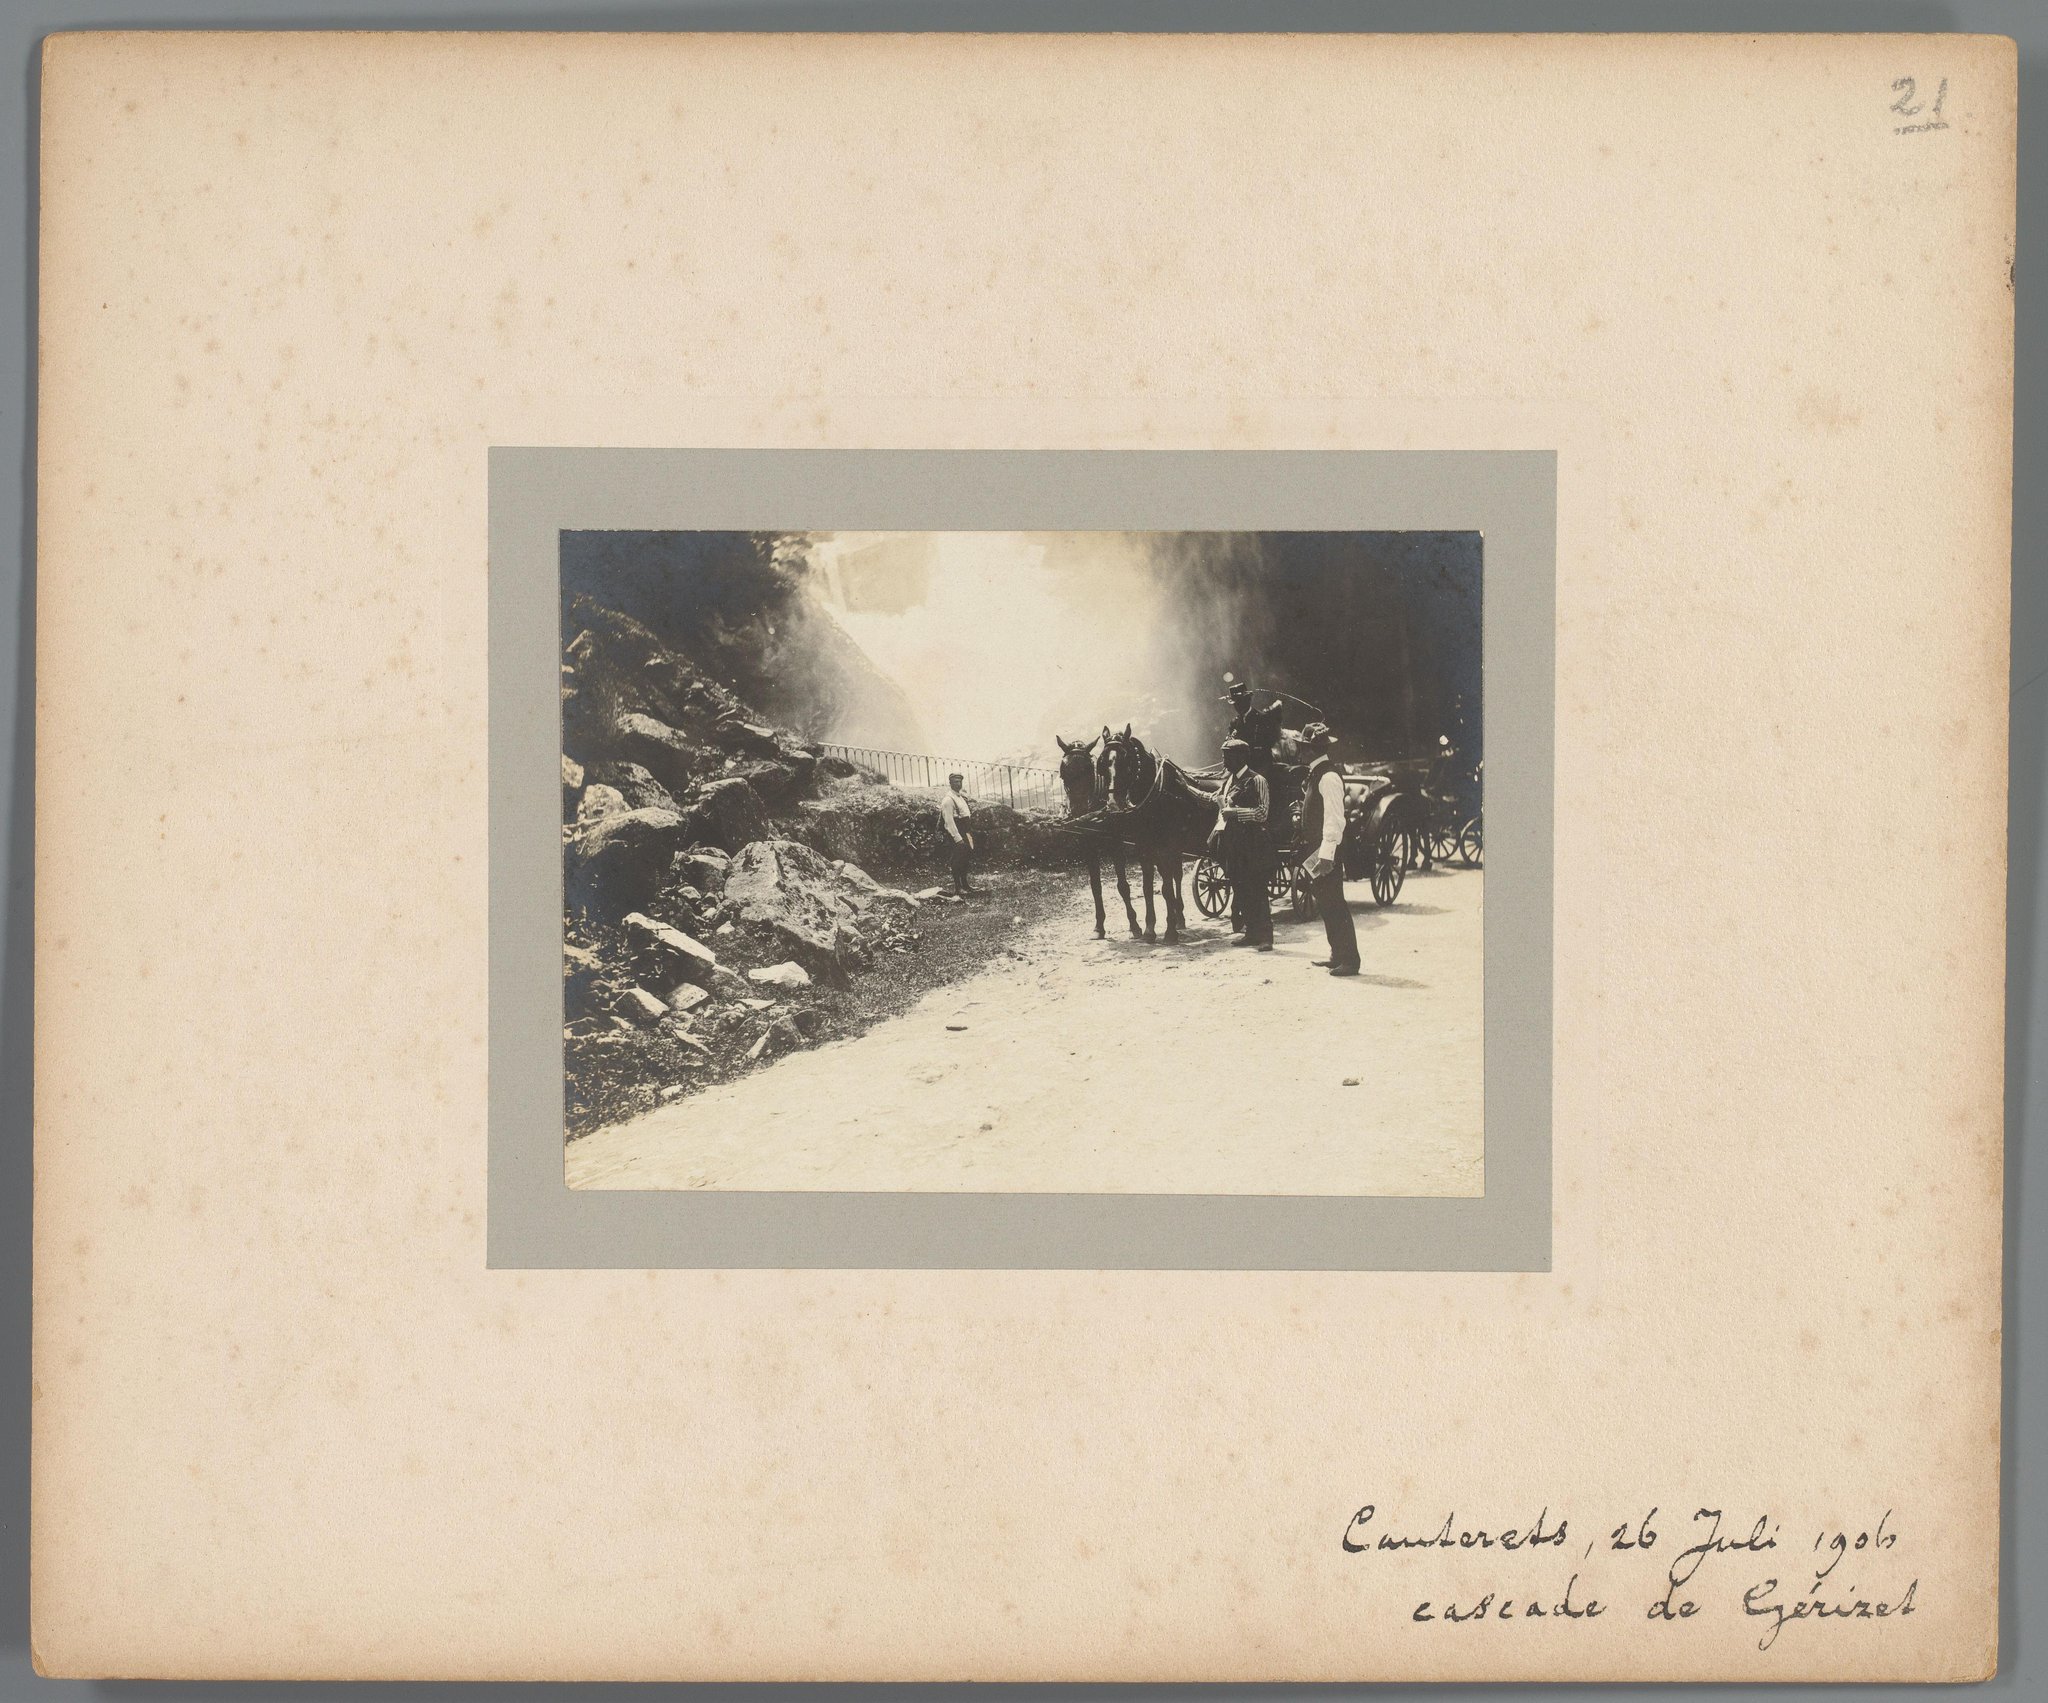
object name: photograph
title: Cauterets, cascade de Gérizet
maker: françois buys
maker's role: advocaat, amateurfotograaf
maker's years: 1871-1934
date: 1906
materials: paper, cardboard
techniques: gelatin silver print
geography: cauterets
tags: waterfall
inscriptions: number: ‘21’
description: Deze foto maakt deel uit van een groep van 49 foto's.